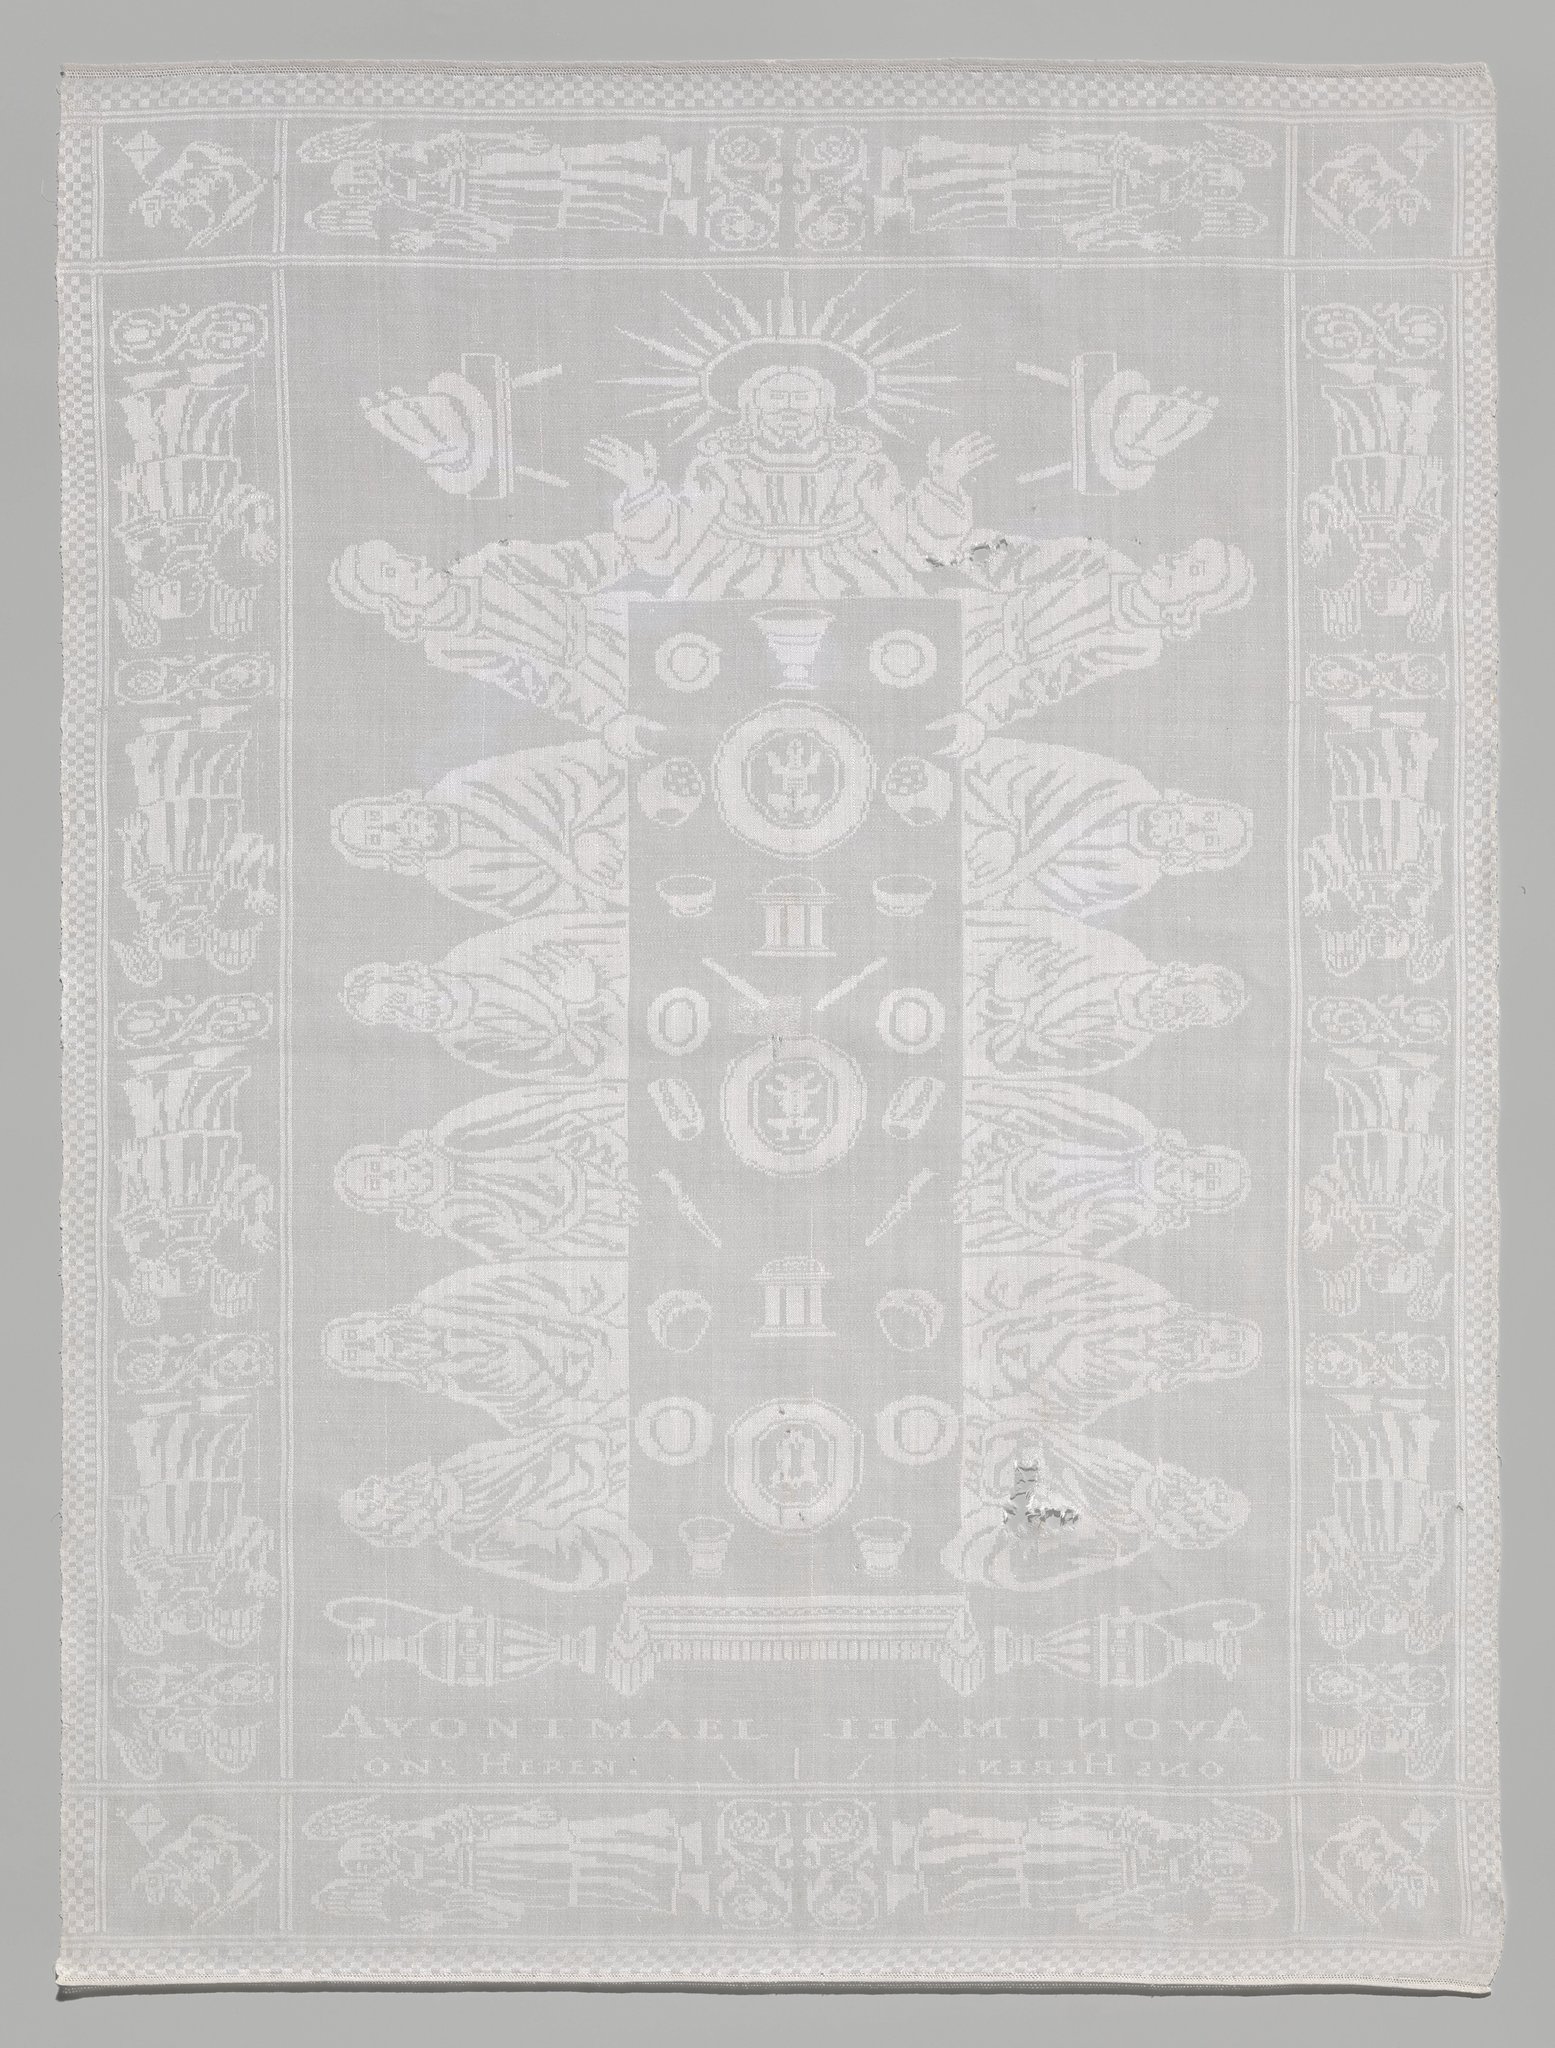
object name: napkin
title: Servet met het Laatste Avondmaal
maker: Anonymous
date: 1610-1640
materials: linen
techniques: damask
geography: northern netherlands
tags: the episode of the last supper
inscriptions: mark: ‘DVG 6’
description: Servet van linnendamast met het Laatste Avondmaal met Christus aan de kop van de tafel. Staande randen met engelen (ondersteboven). Satijn 5 binding.